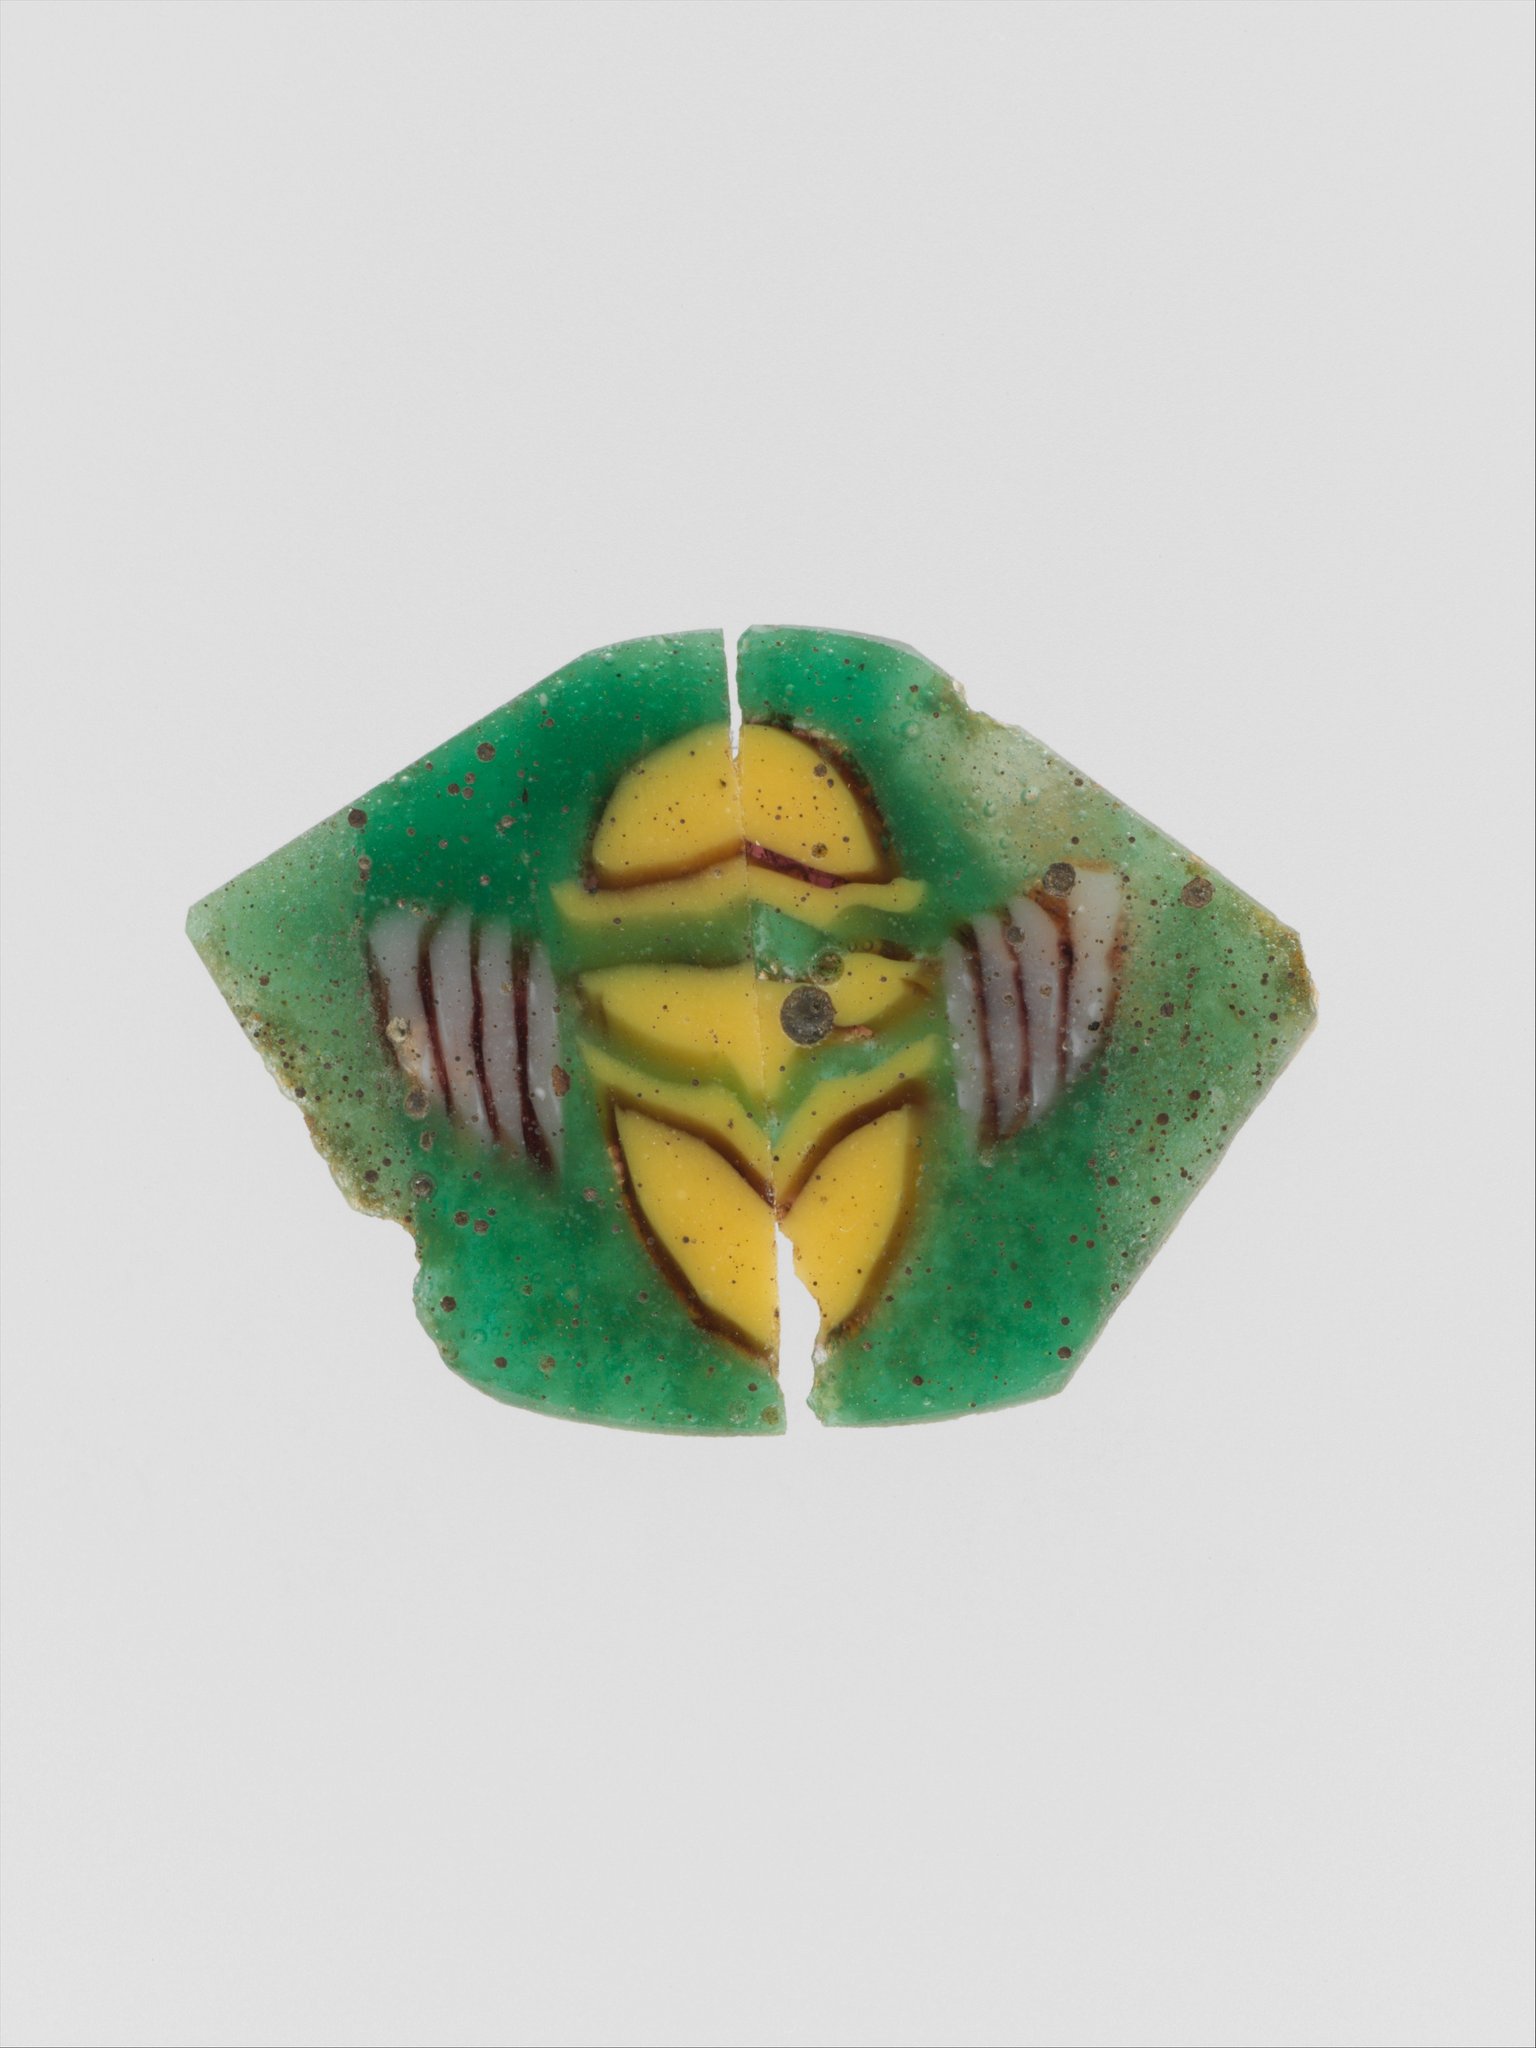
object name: mosaic block inlay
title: Glass mosaic inlay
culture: egyptian or ptolemaic or roman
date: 34 BCE-33 CE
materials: glass